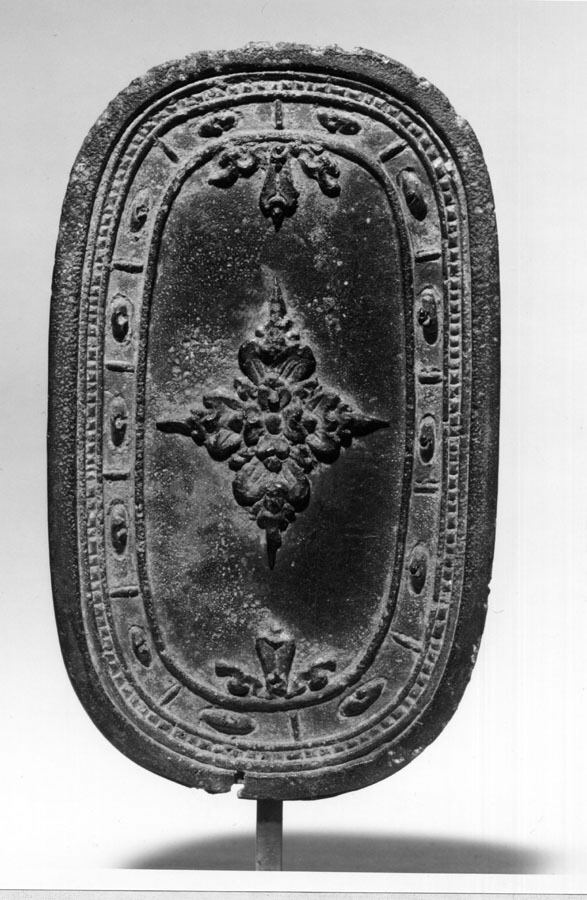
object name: box with lid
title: Oval Box Lid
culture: indonesian, javanese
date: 901-1100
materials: bronze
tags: flowers